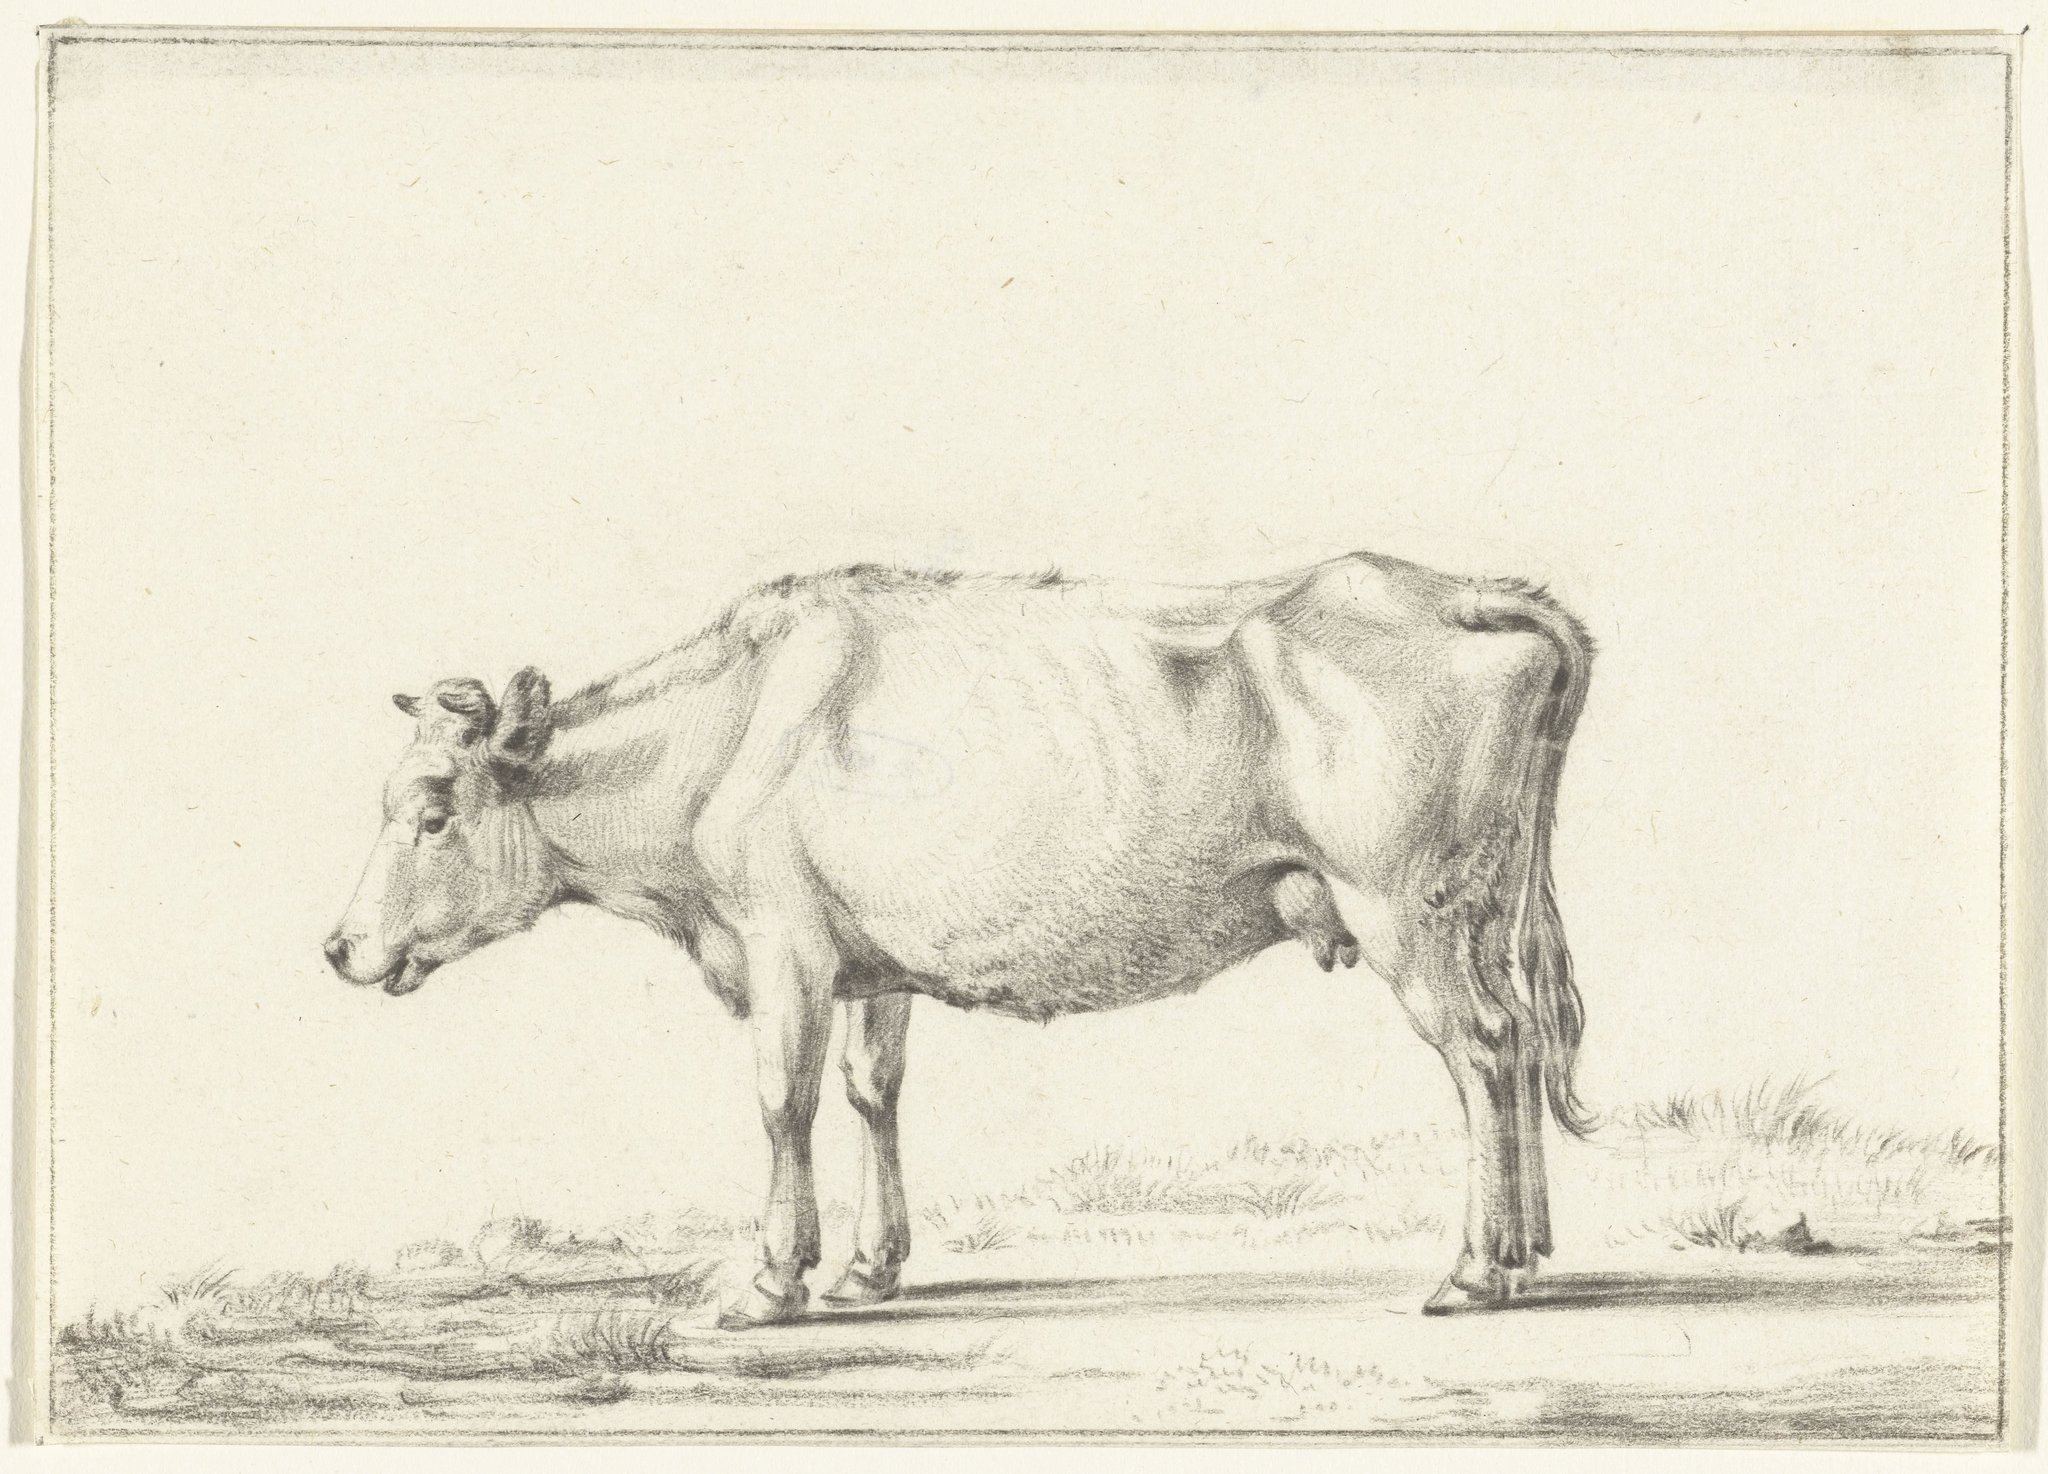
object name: drawing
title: Staande koe, naar links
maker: jean bernard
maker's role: draughtsman, print maker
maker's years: 1765-1833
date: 1775-1833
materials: chalk, paper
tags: cow